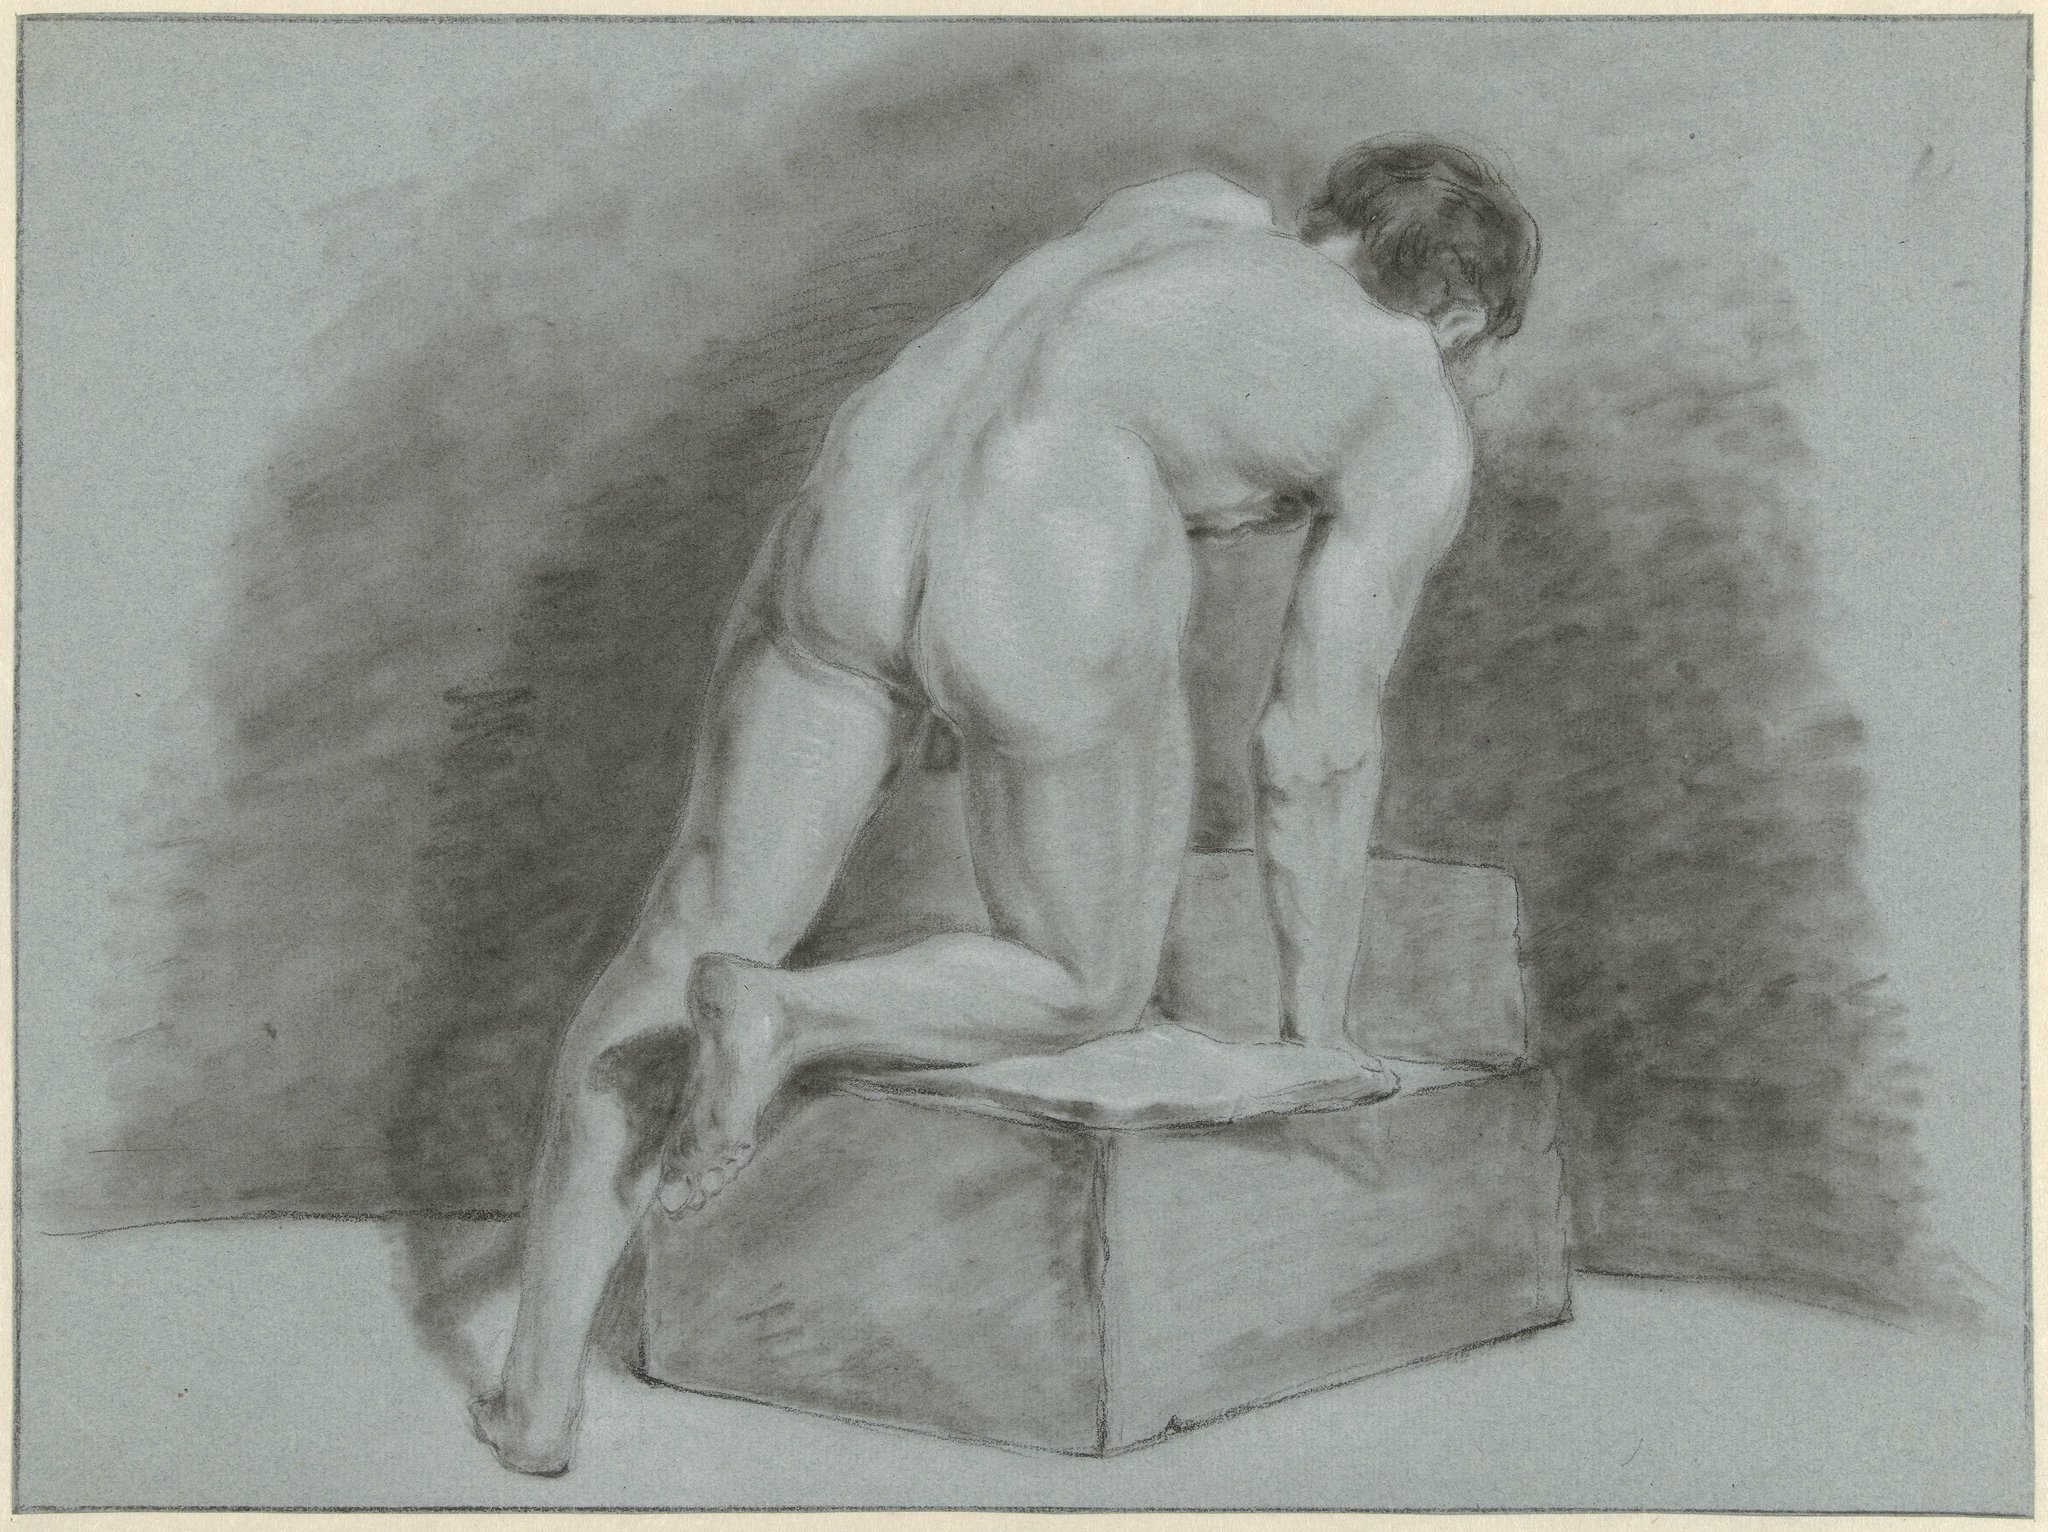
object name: drawing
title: Mannelijk naakt, voorovergebogen, op de rug gezien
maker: aert schouman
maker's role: draughtsman, painter, print maker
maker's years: 1710-1792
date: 1720-1792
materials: chalk, paper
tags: kneeling figure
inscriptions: inscription: ‘VPV-156 / A. Schouman’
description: Mannelijk naakt, voorovergebogen, steunend op de rechterknie en de rechterhand, op de rug gezien.